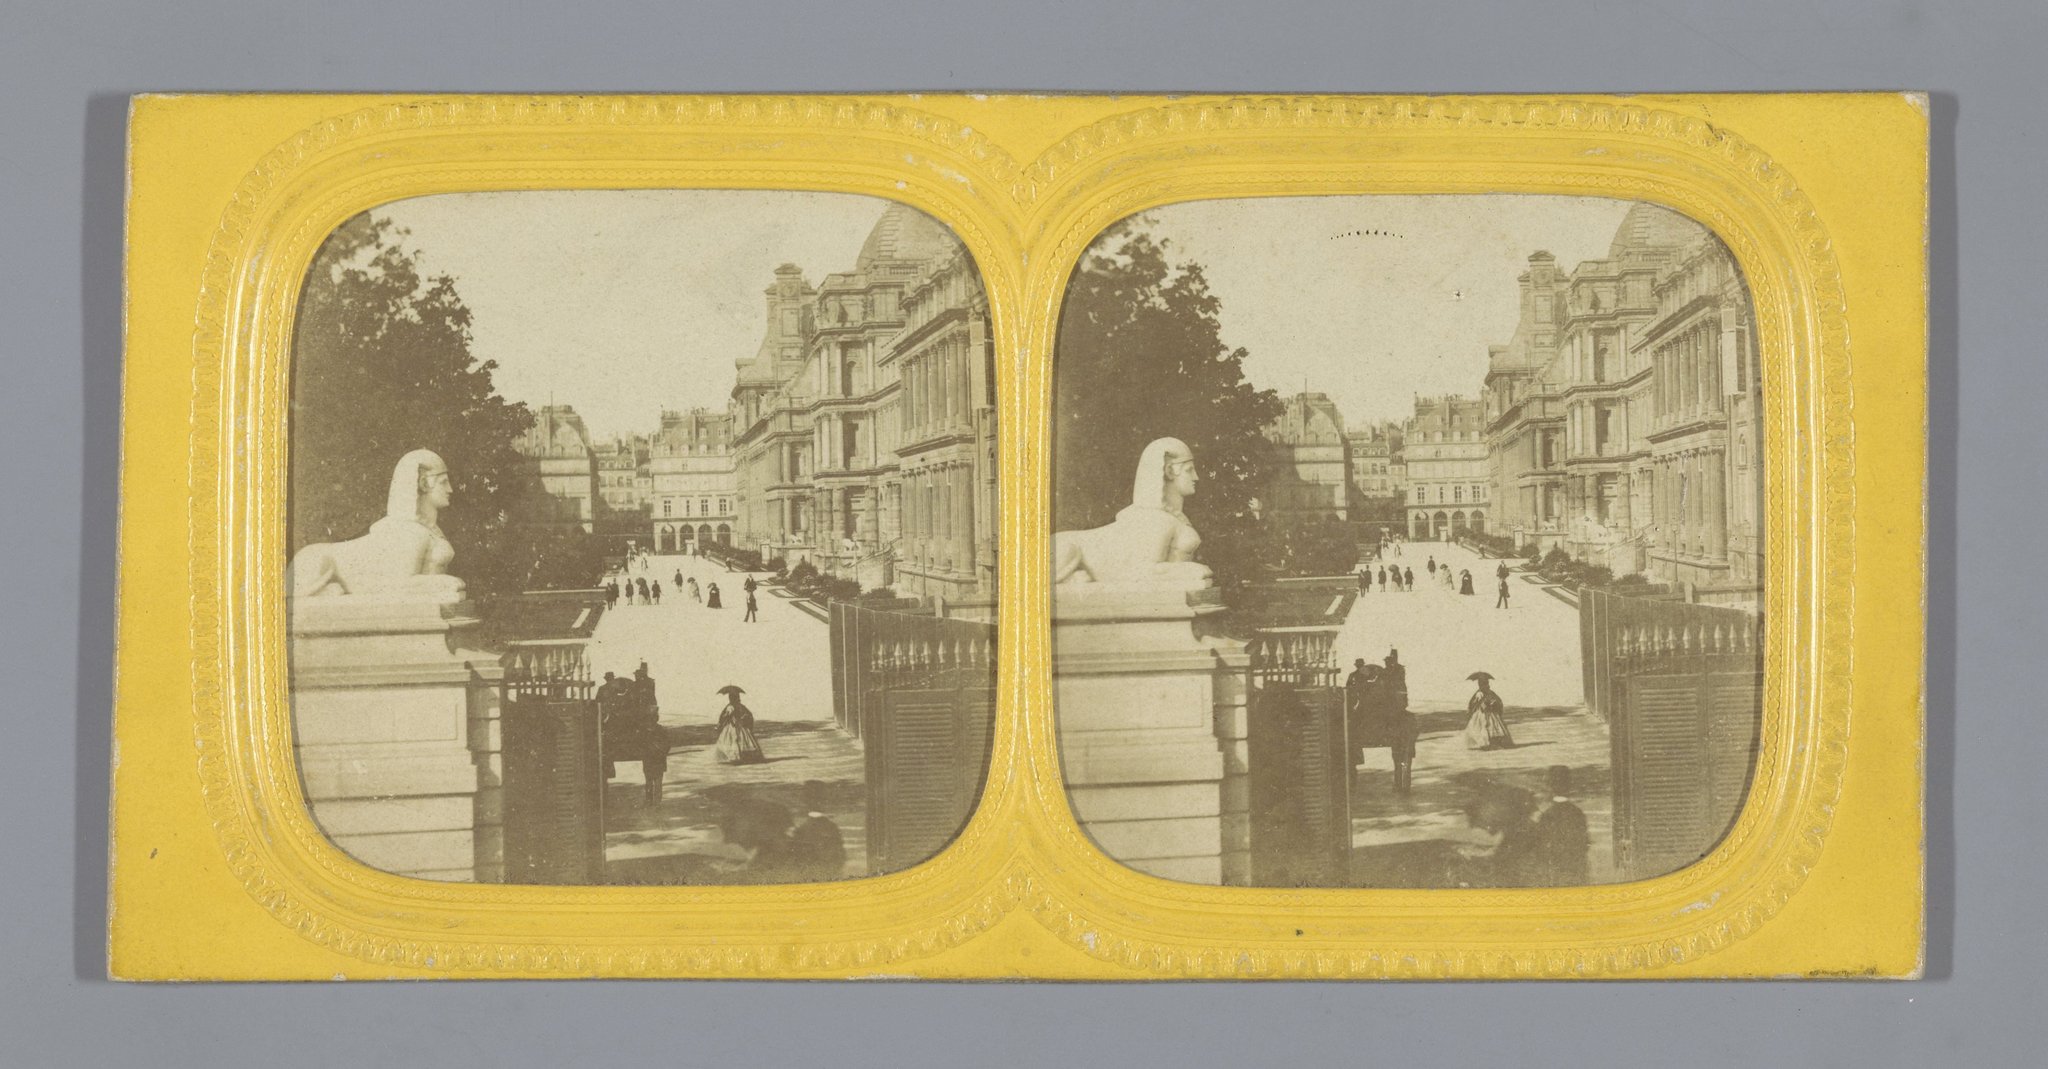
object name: tissue stereograph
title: Tuilerieën met rechts het Tuilerieënpaleis, Parijs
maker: Anonymous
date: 1855-1871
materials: cardboard, paper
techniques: albumen print, hand coloring, perforating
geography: paris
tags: park, sphinx (lion/woman); 'sfinge' (ripa), public gardens, park, tuileries palace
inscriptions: inscription: ‘60 dro/ mio [onz]’